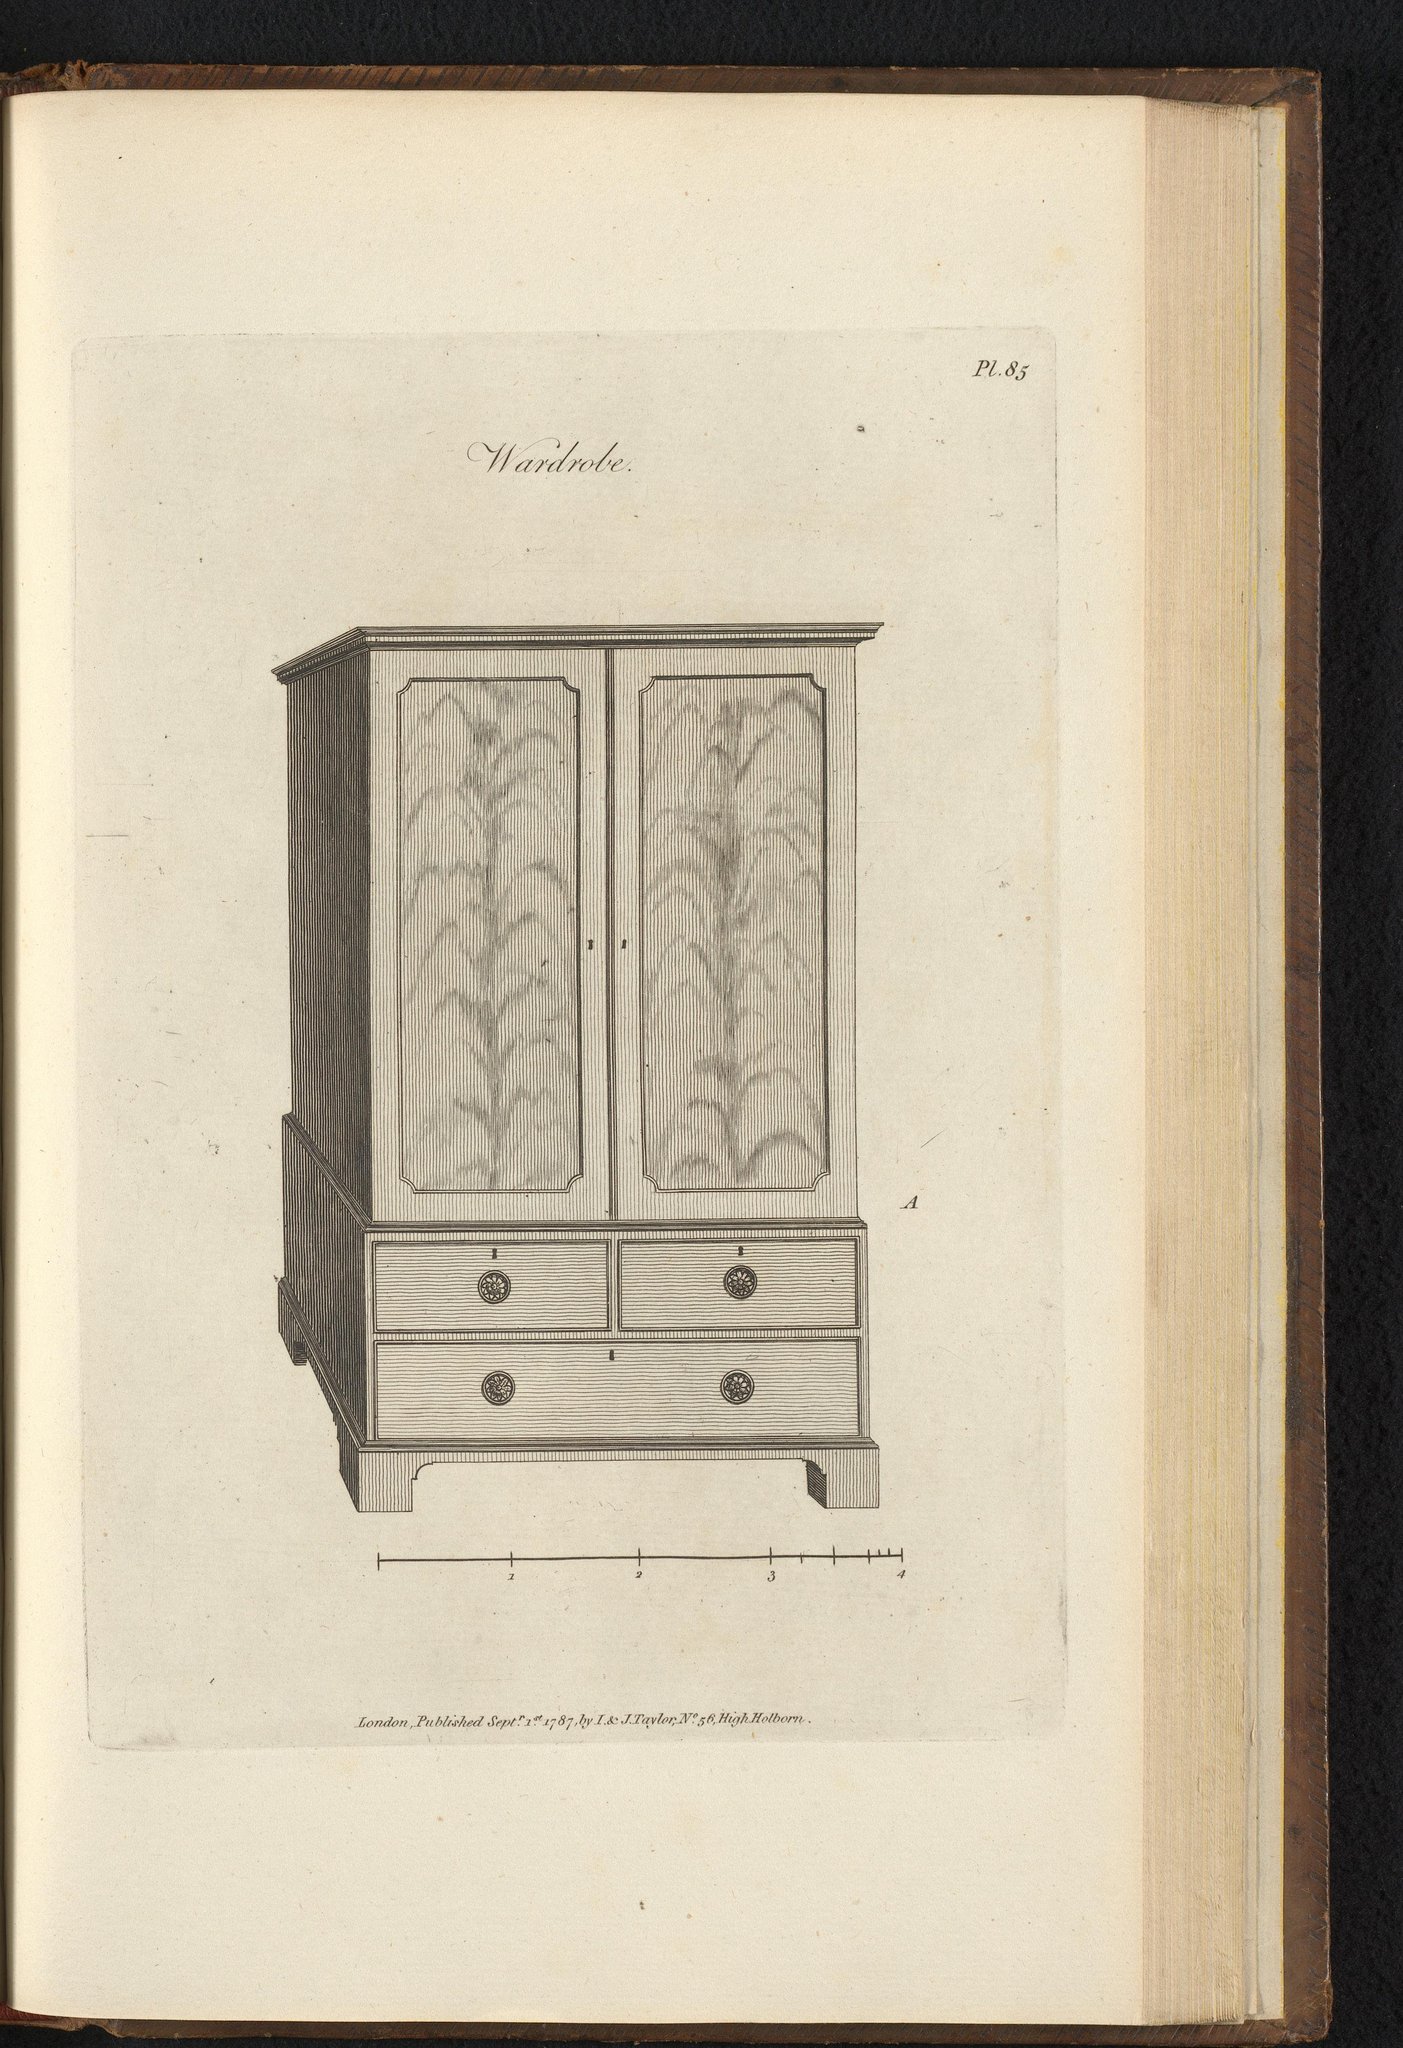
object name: print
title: Wardrobe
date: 1787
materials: paper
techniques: engraving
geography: holborn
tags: wardrobe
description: Genummerd: Pl. 85. Kast gemerkt als: A. Schaalverdeling in de ondermarge. Prent maakt deel uit van een boek.